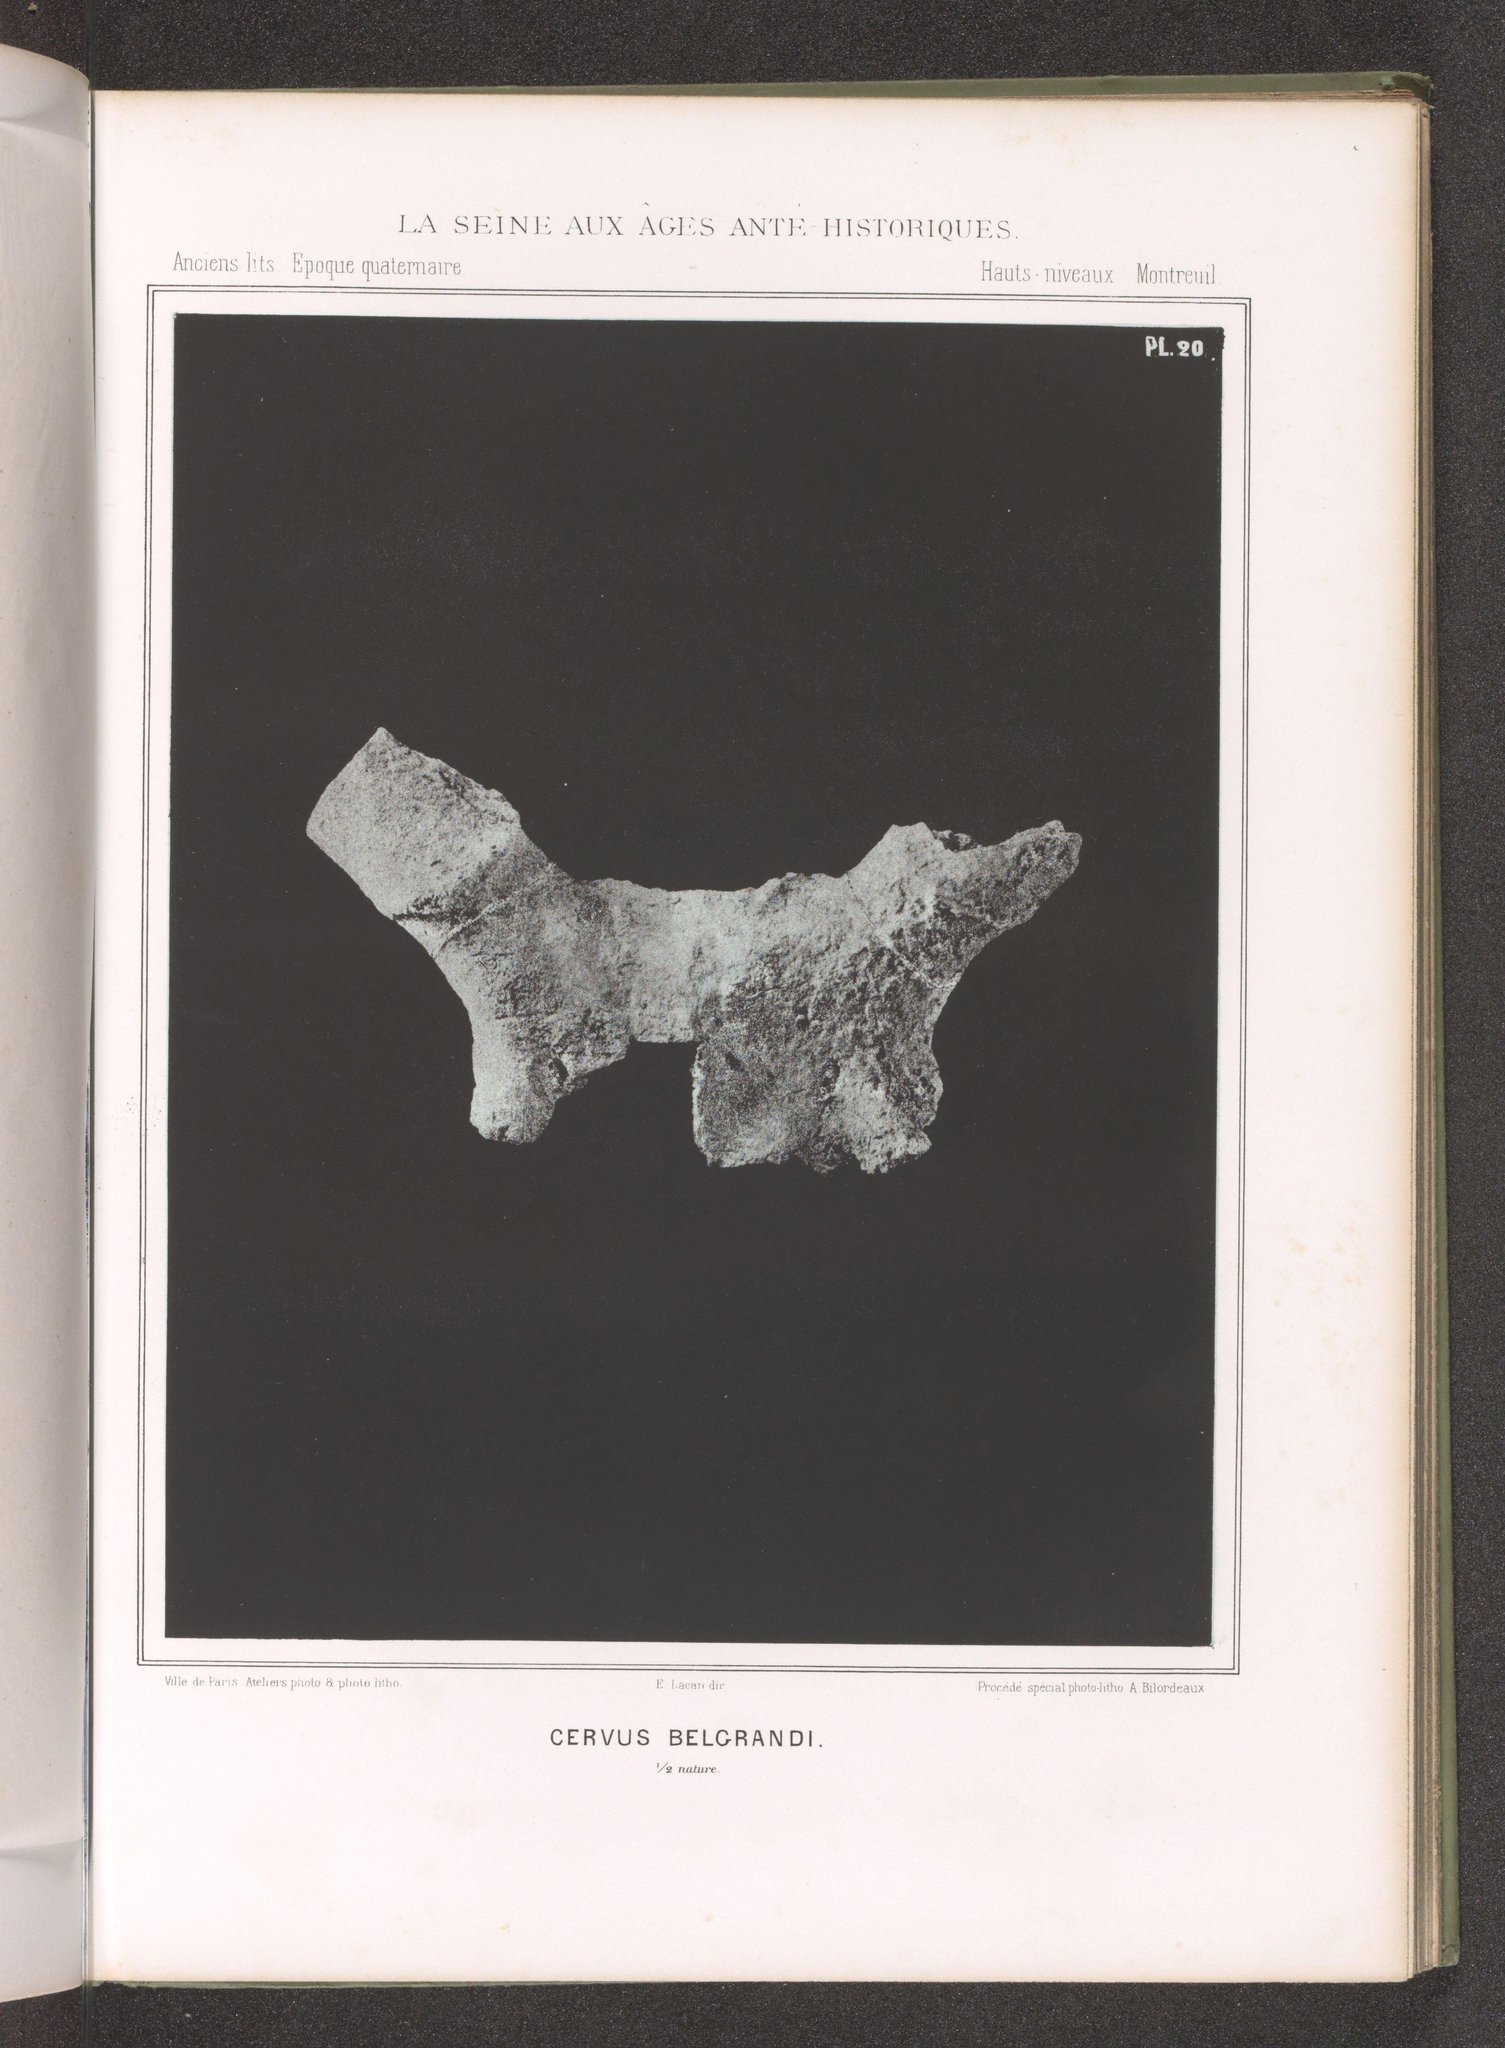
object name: photomechanical print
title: CERVUS BELGRANDI. 1/2 nature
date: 1860-1869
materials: paper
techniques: photolithography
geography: paris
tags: animals (+ skeleton of an animal), palaeontology, france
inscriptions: inscription: ‘Ville de Paris Ateliers photo & litho-photo. E. Lacan, dir. Procédé spécial photo-litho A. Bilordeaux’, number: ‘Pl. 20’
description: Voor plek prent in boek: zie nummer onder 'Opschriften / Merken'.